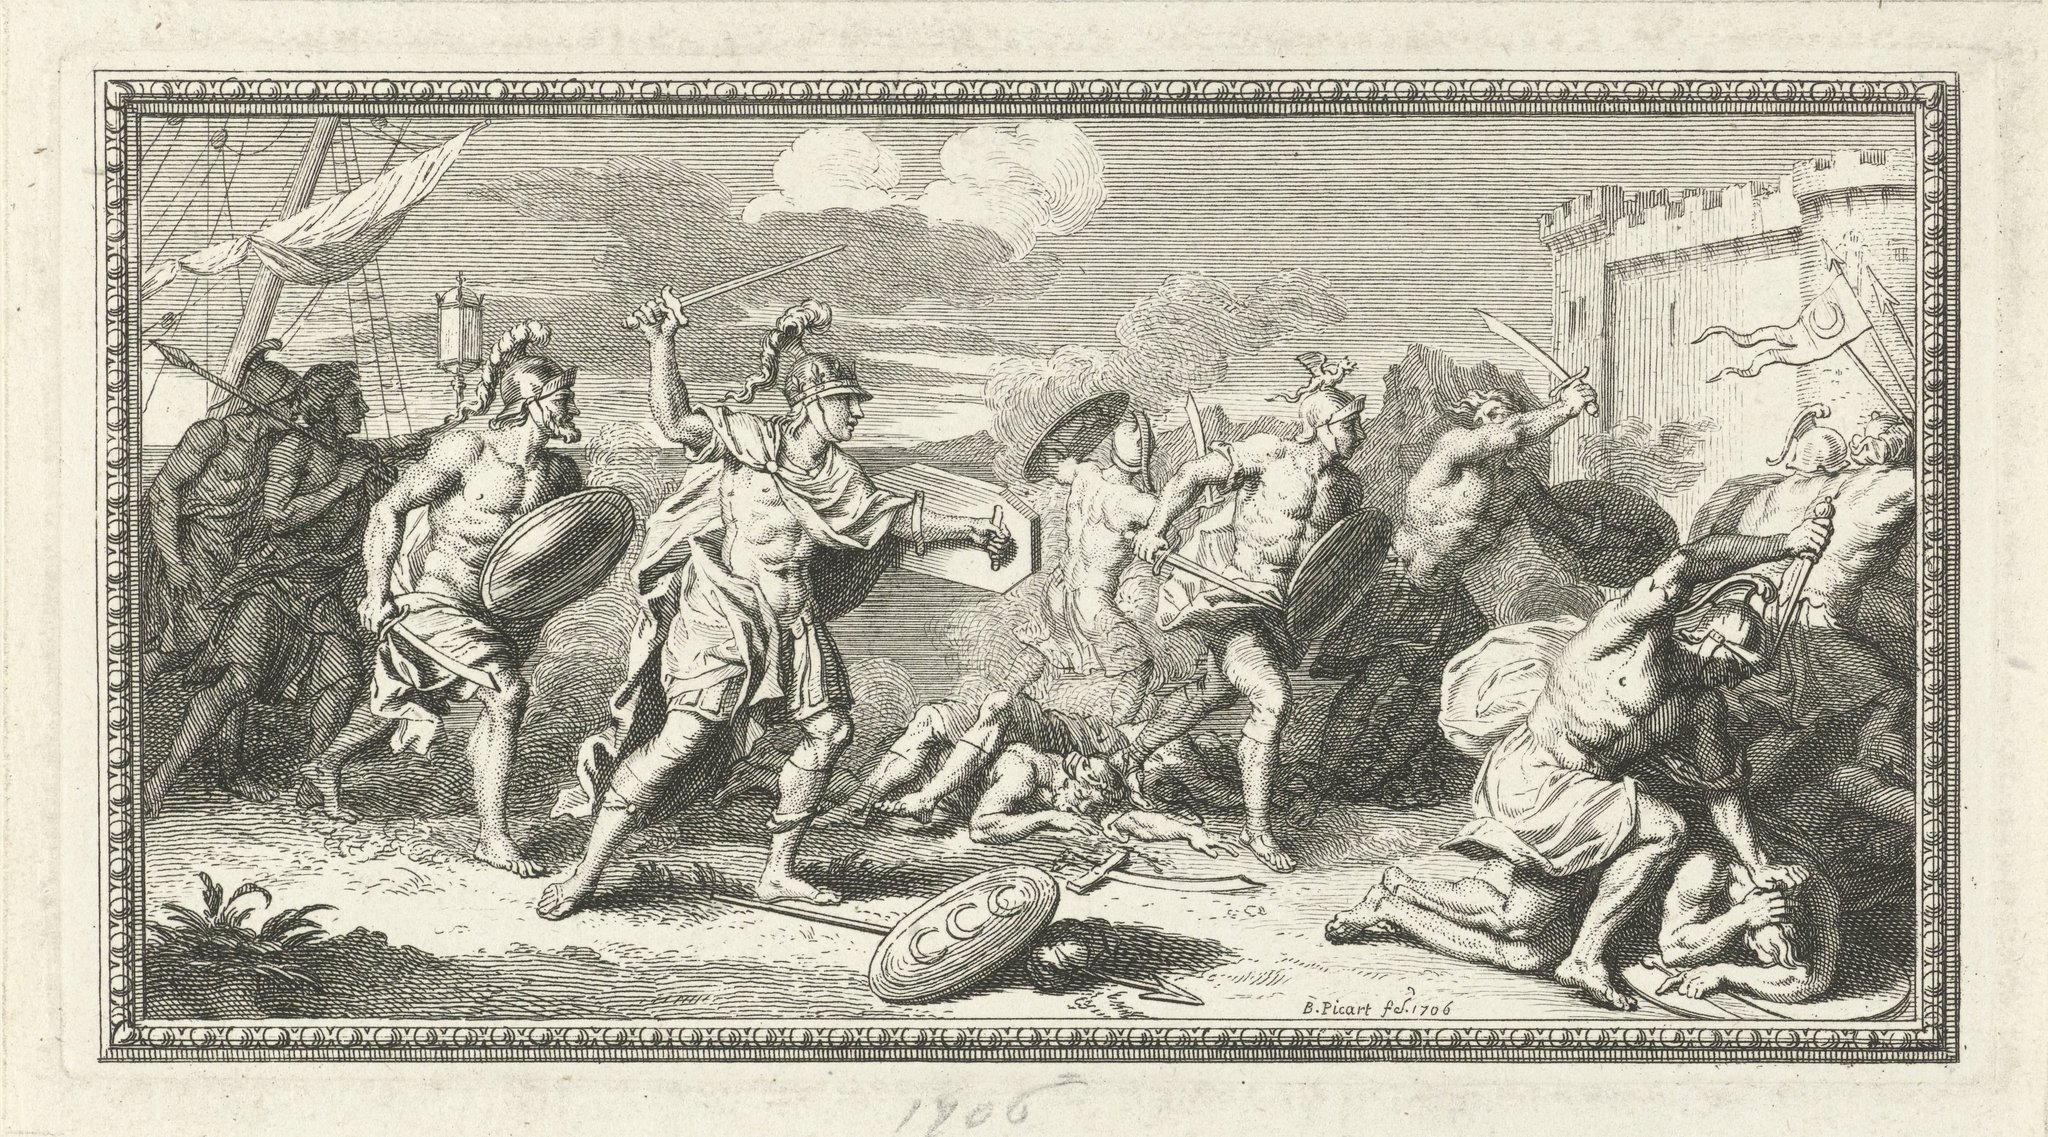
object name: print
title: Soldaten bestormen een burcht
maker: bernard picart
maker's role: draughtsman, print maker, publisher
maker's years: 1673-1733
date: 1706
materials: paper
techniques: engraving, etching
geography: paris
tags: fortress, militant proselytizing: religious war, crusade, etc., persecution of believers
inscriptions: collector's mark: Lugt 240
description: Christelijke soldaten die met hun schip zijn aangemeerd bestormen een burcht. Op hun weg doden zij de islamitische verdedigers. Op de voorgrond een schild waarop de Turkse halve maan.